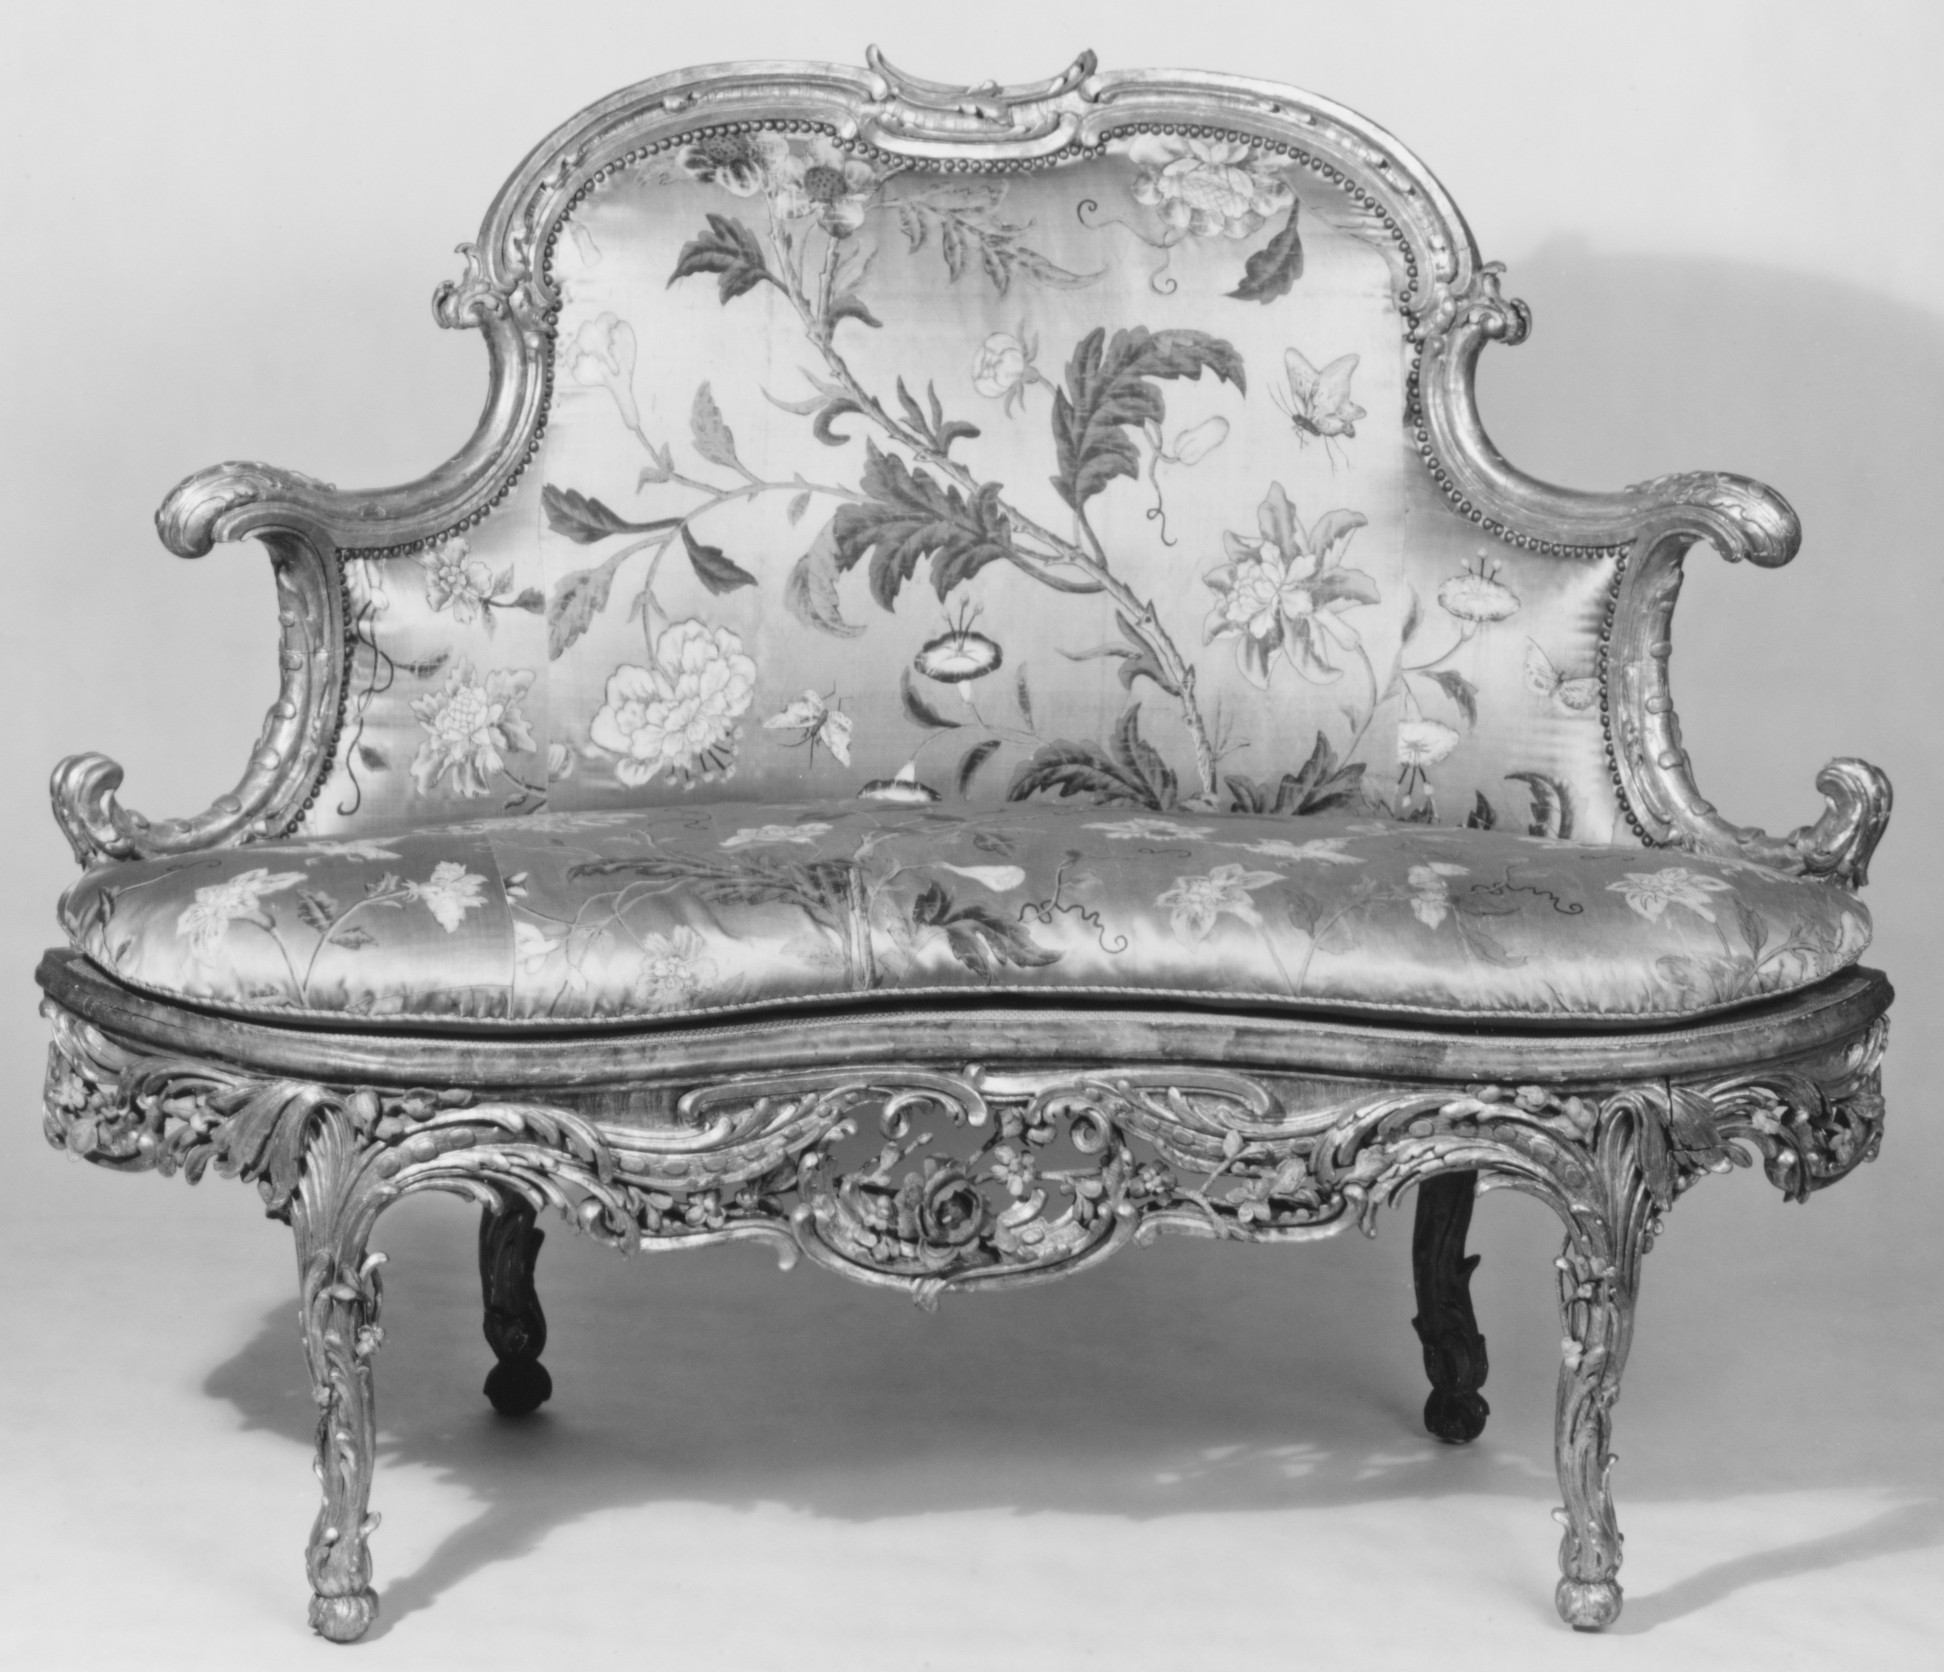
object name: upholstery panel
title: Upholstery panels for a settee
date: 1763-1764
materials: silk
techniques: painting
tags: flowers